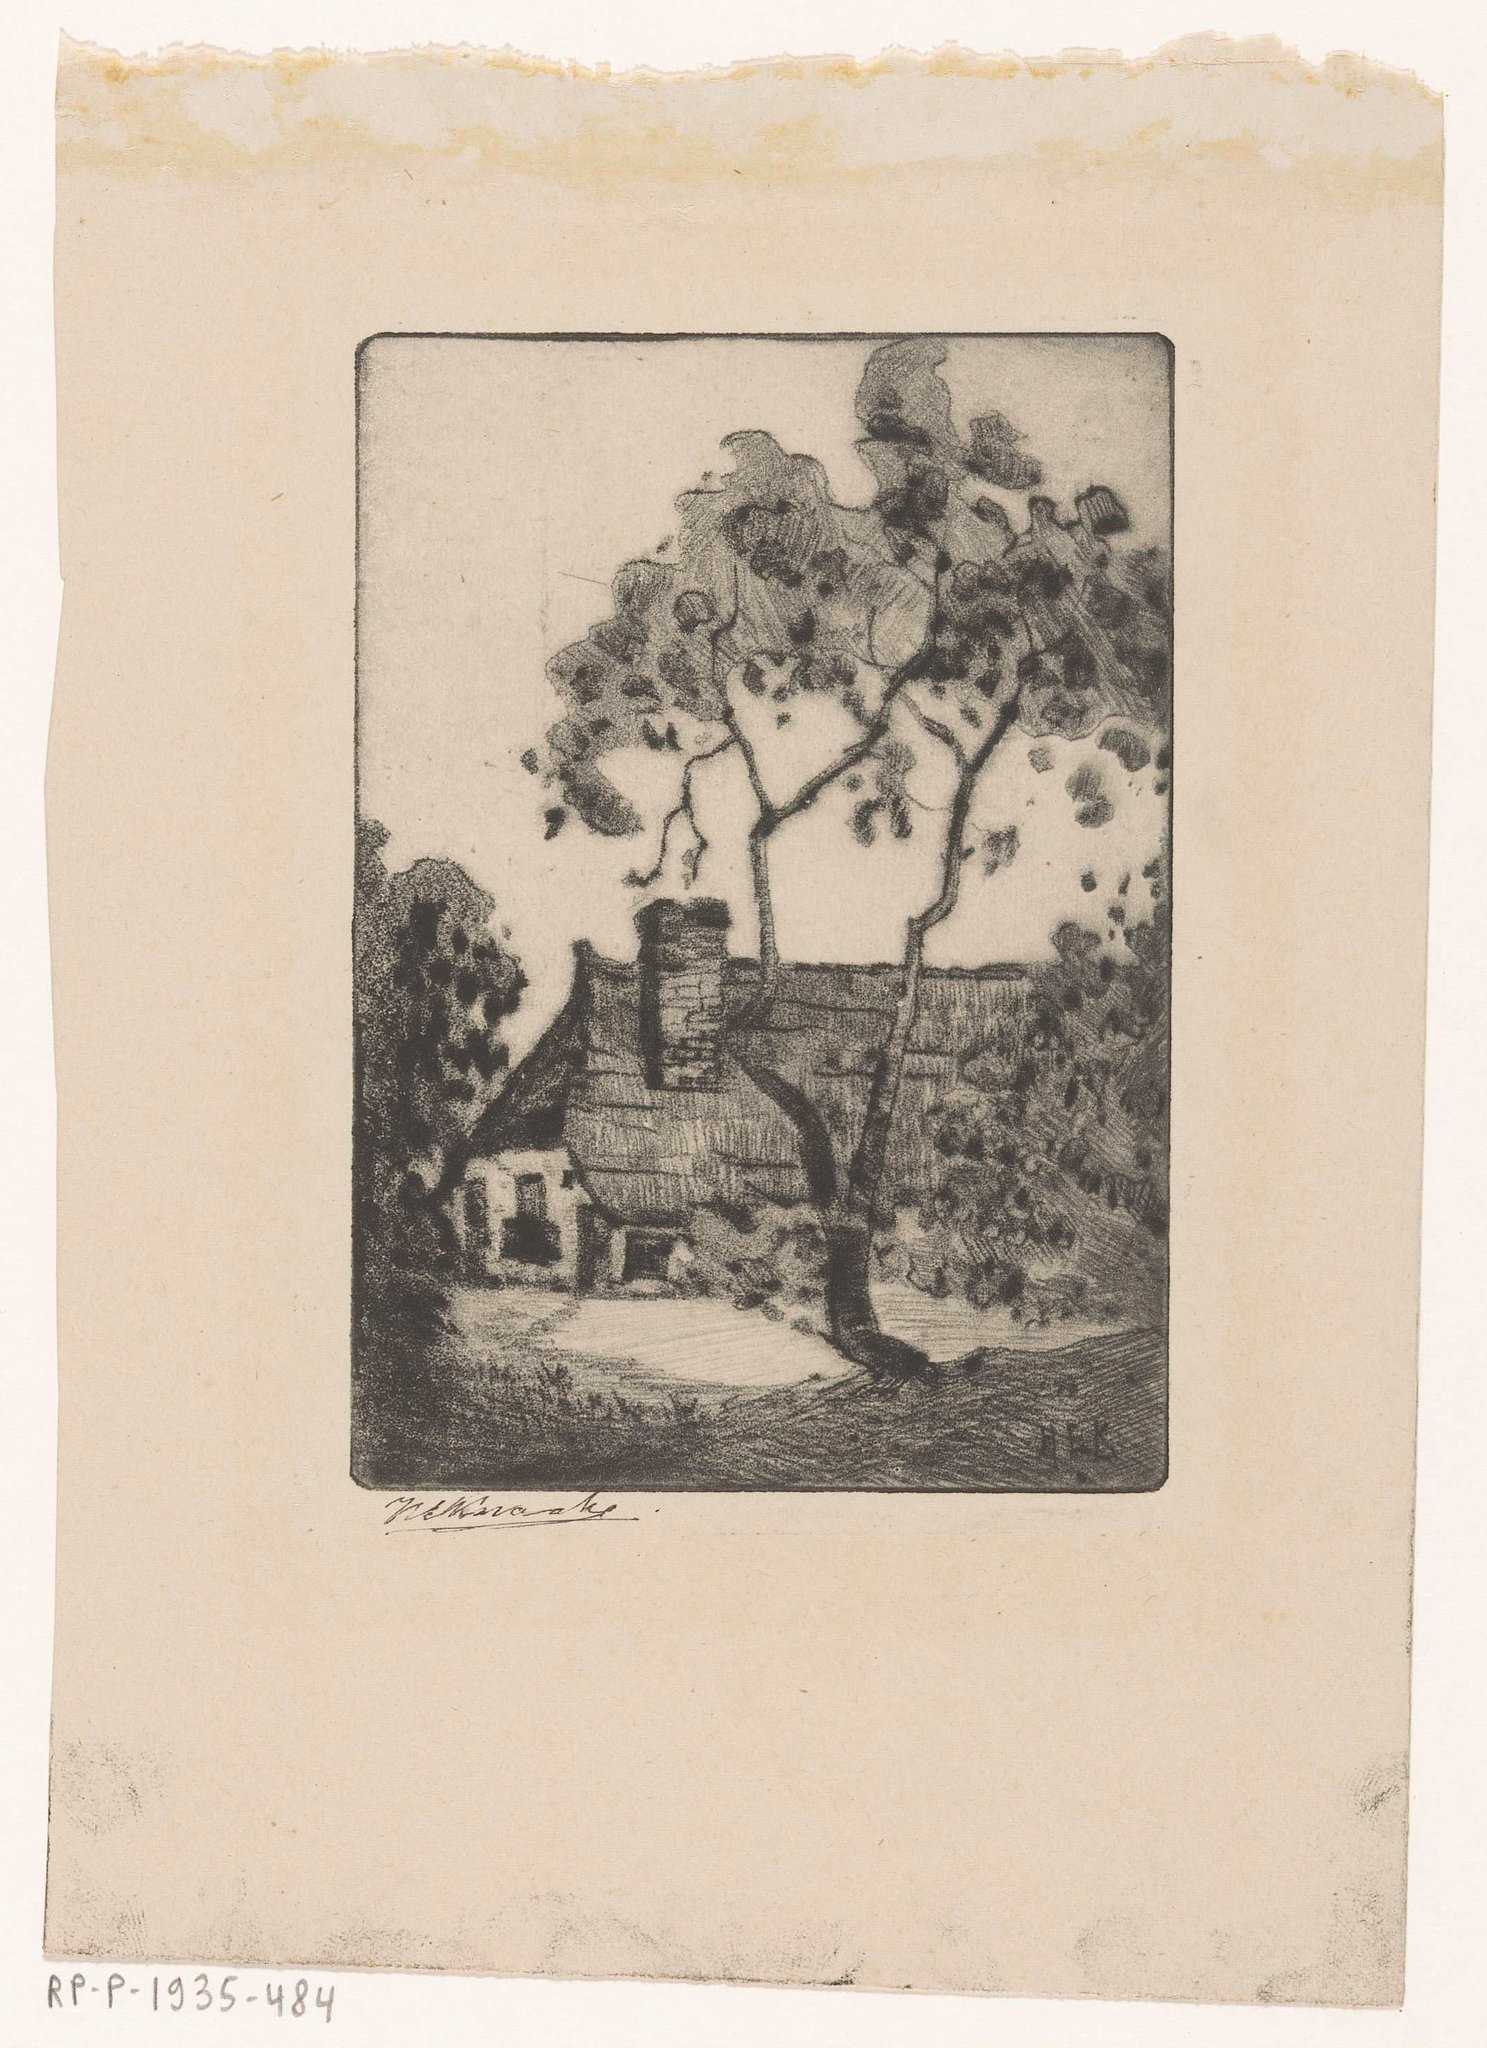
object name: print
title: Boom bij een boerderij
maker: herman eduard knaake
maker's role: draughtsman, print maker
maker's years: 1863-1948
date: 1873-1935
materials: paper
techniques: etching, intaglio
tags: trees, farm or solitary house in landscape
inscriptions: collector's mark: Lugt 2228